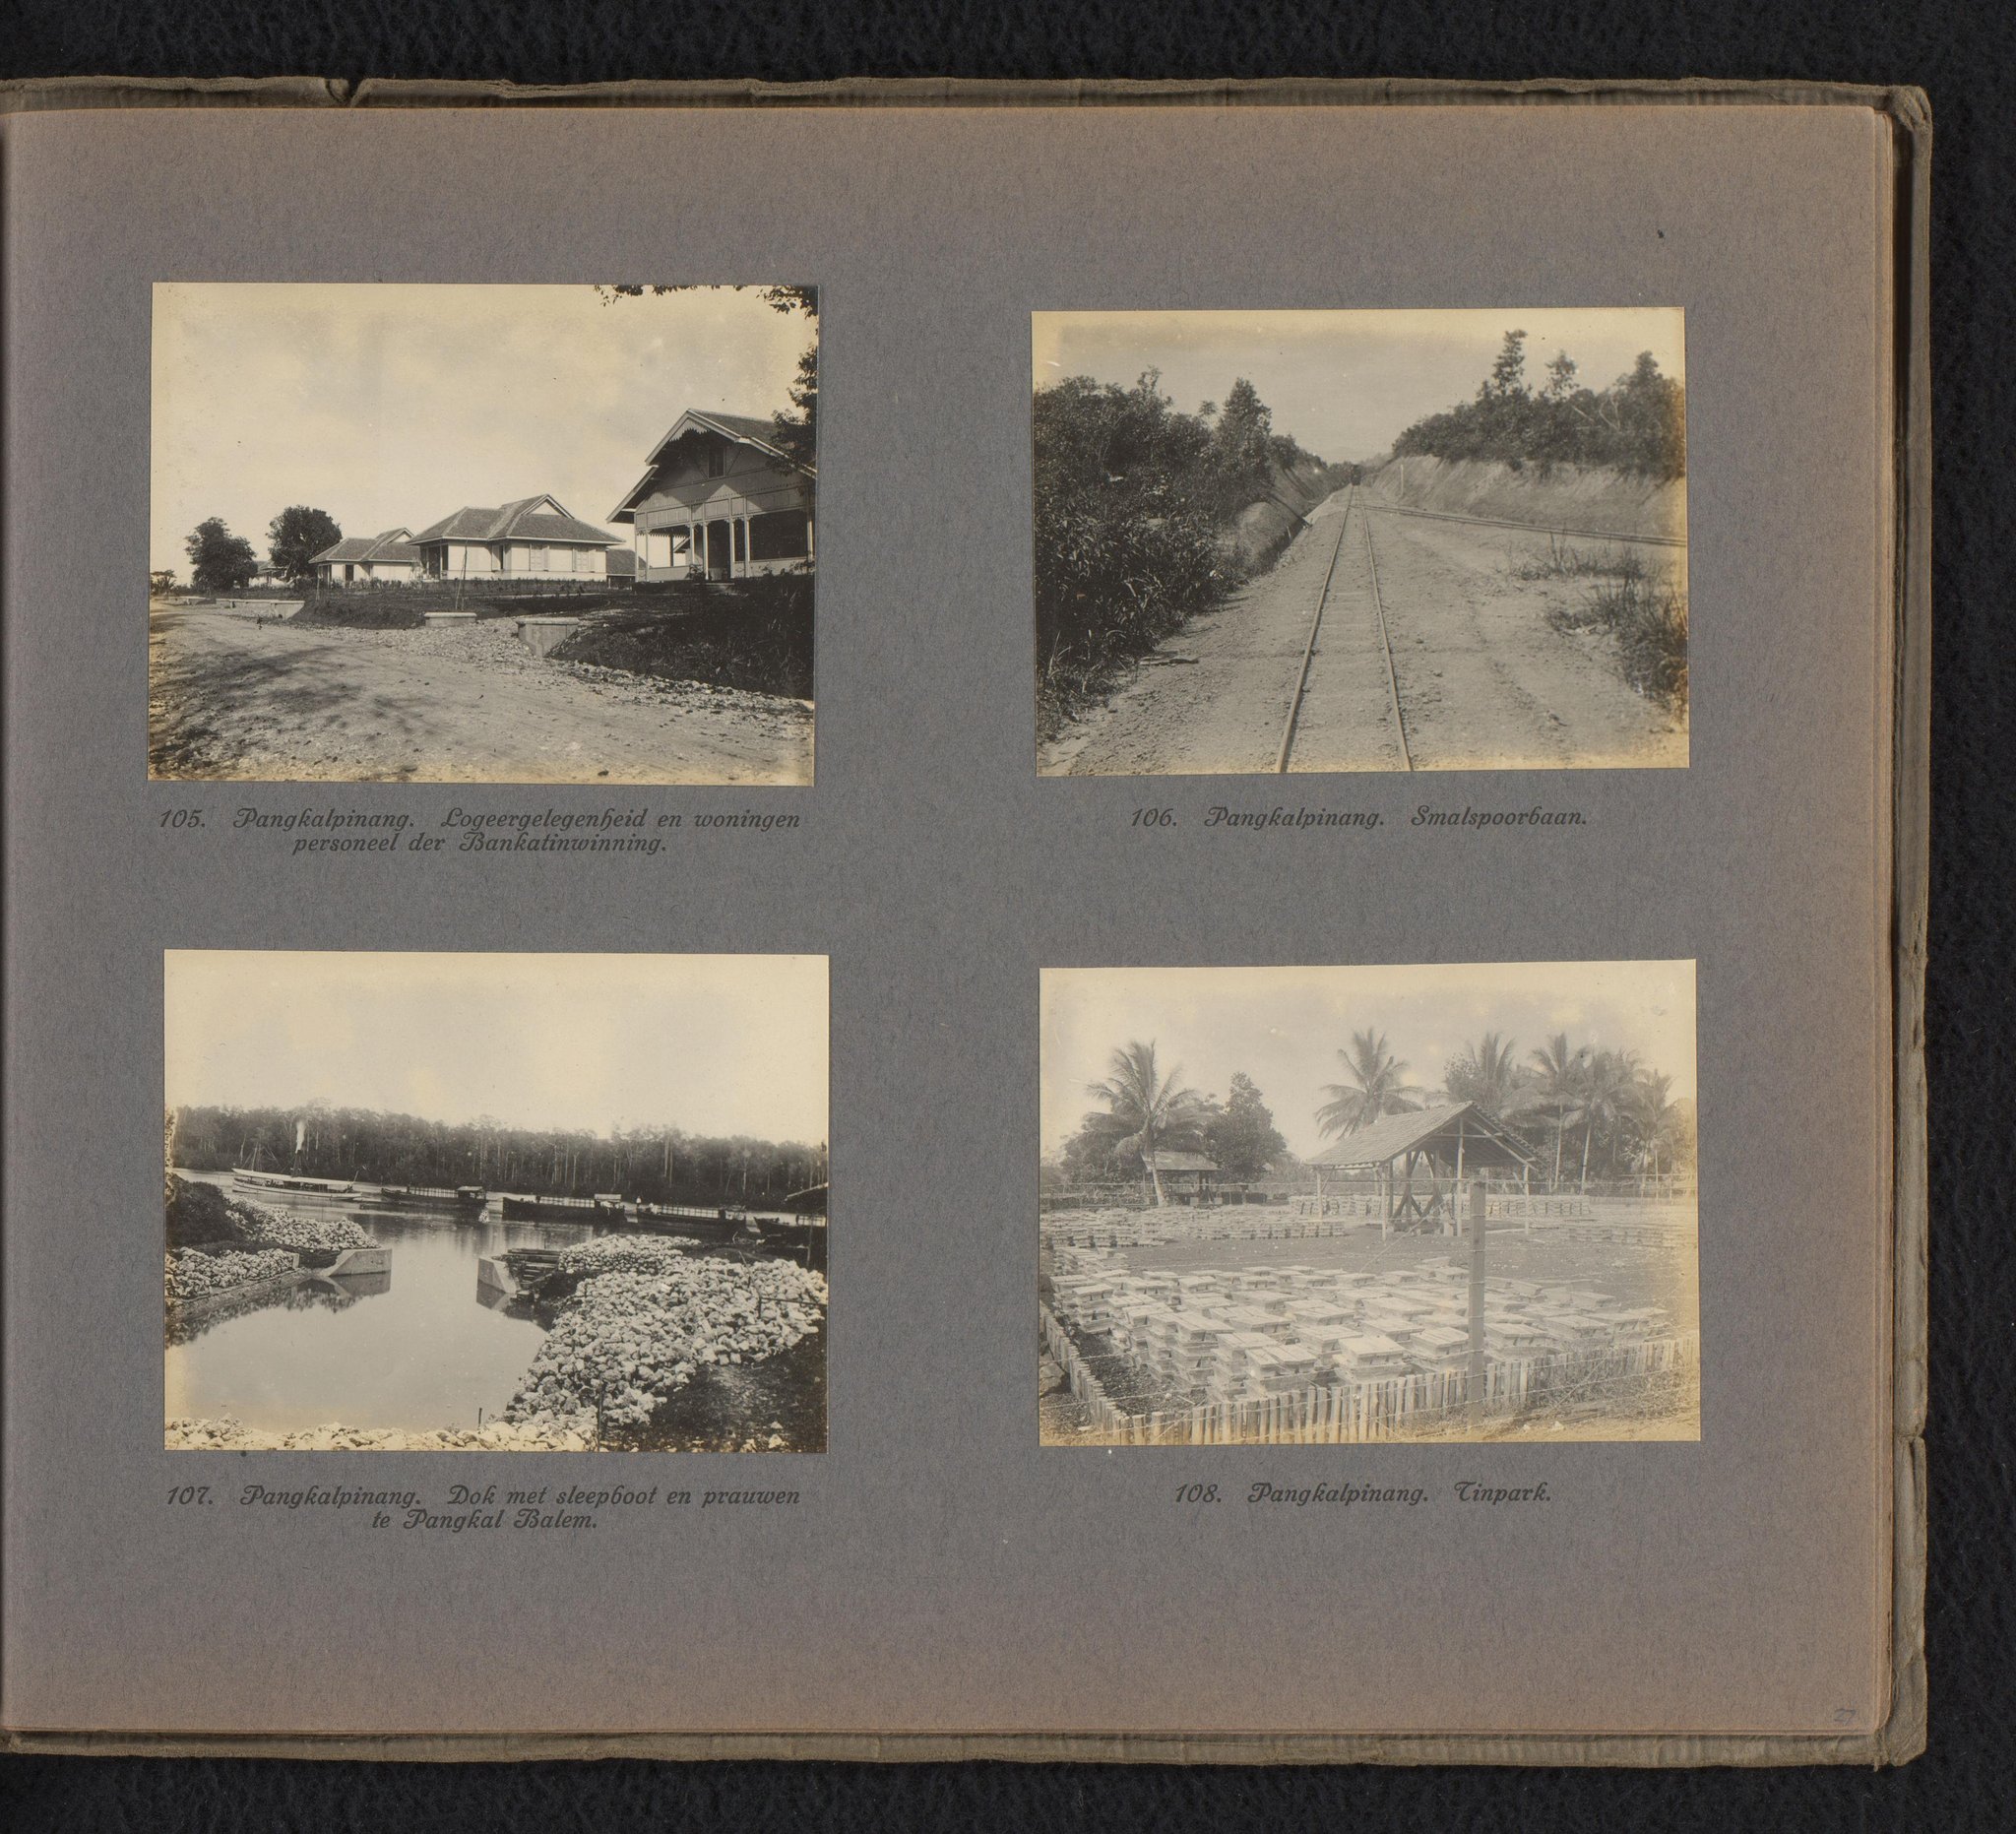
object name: photograph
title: Gezichten te Pangkalpinang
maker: Anonymous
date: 1907-1919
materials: cardboard, photographic support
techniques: gelatin silver print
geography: bangka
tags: robert julius boers, colonial system, rural housing, e.g. country-house, villa, cottage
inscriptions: inscription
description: Albumblad met vier foto's genummerd 105-108 van verschillende gezichten van gebouwen van de Banka-tinwinning te Pangkalpinang op Banka. Onderdeel van het Banka-Album met foto's over het eiland Banka en de tinwinning door het staatsbedrijf de Banka-tinwinning in de periode ca. 1907-1919.